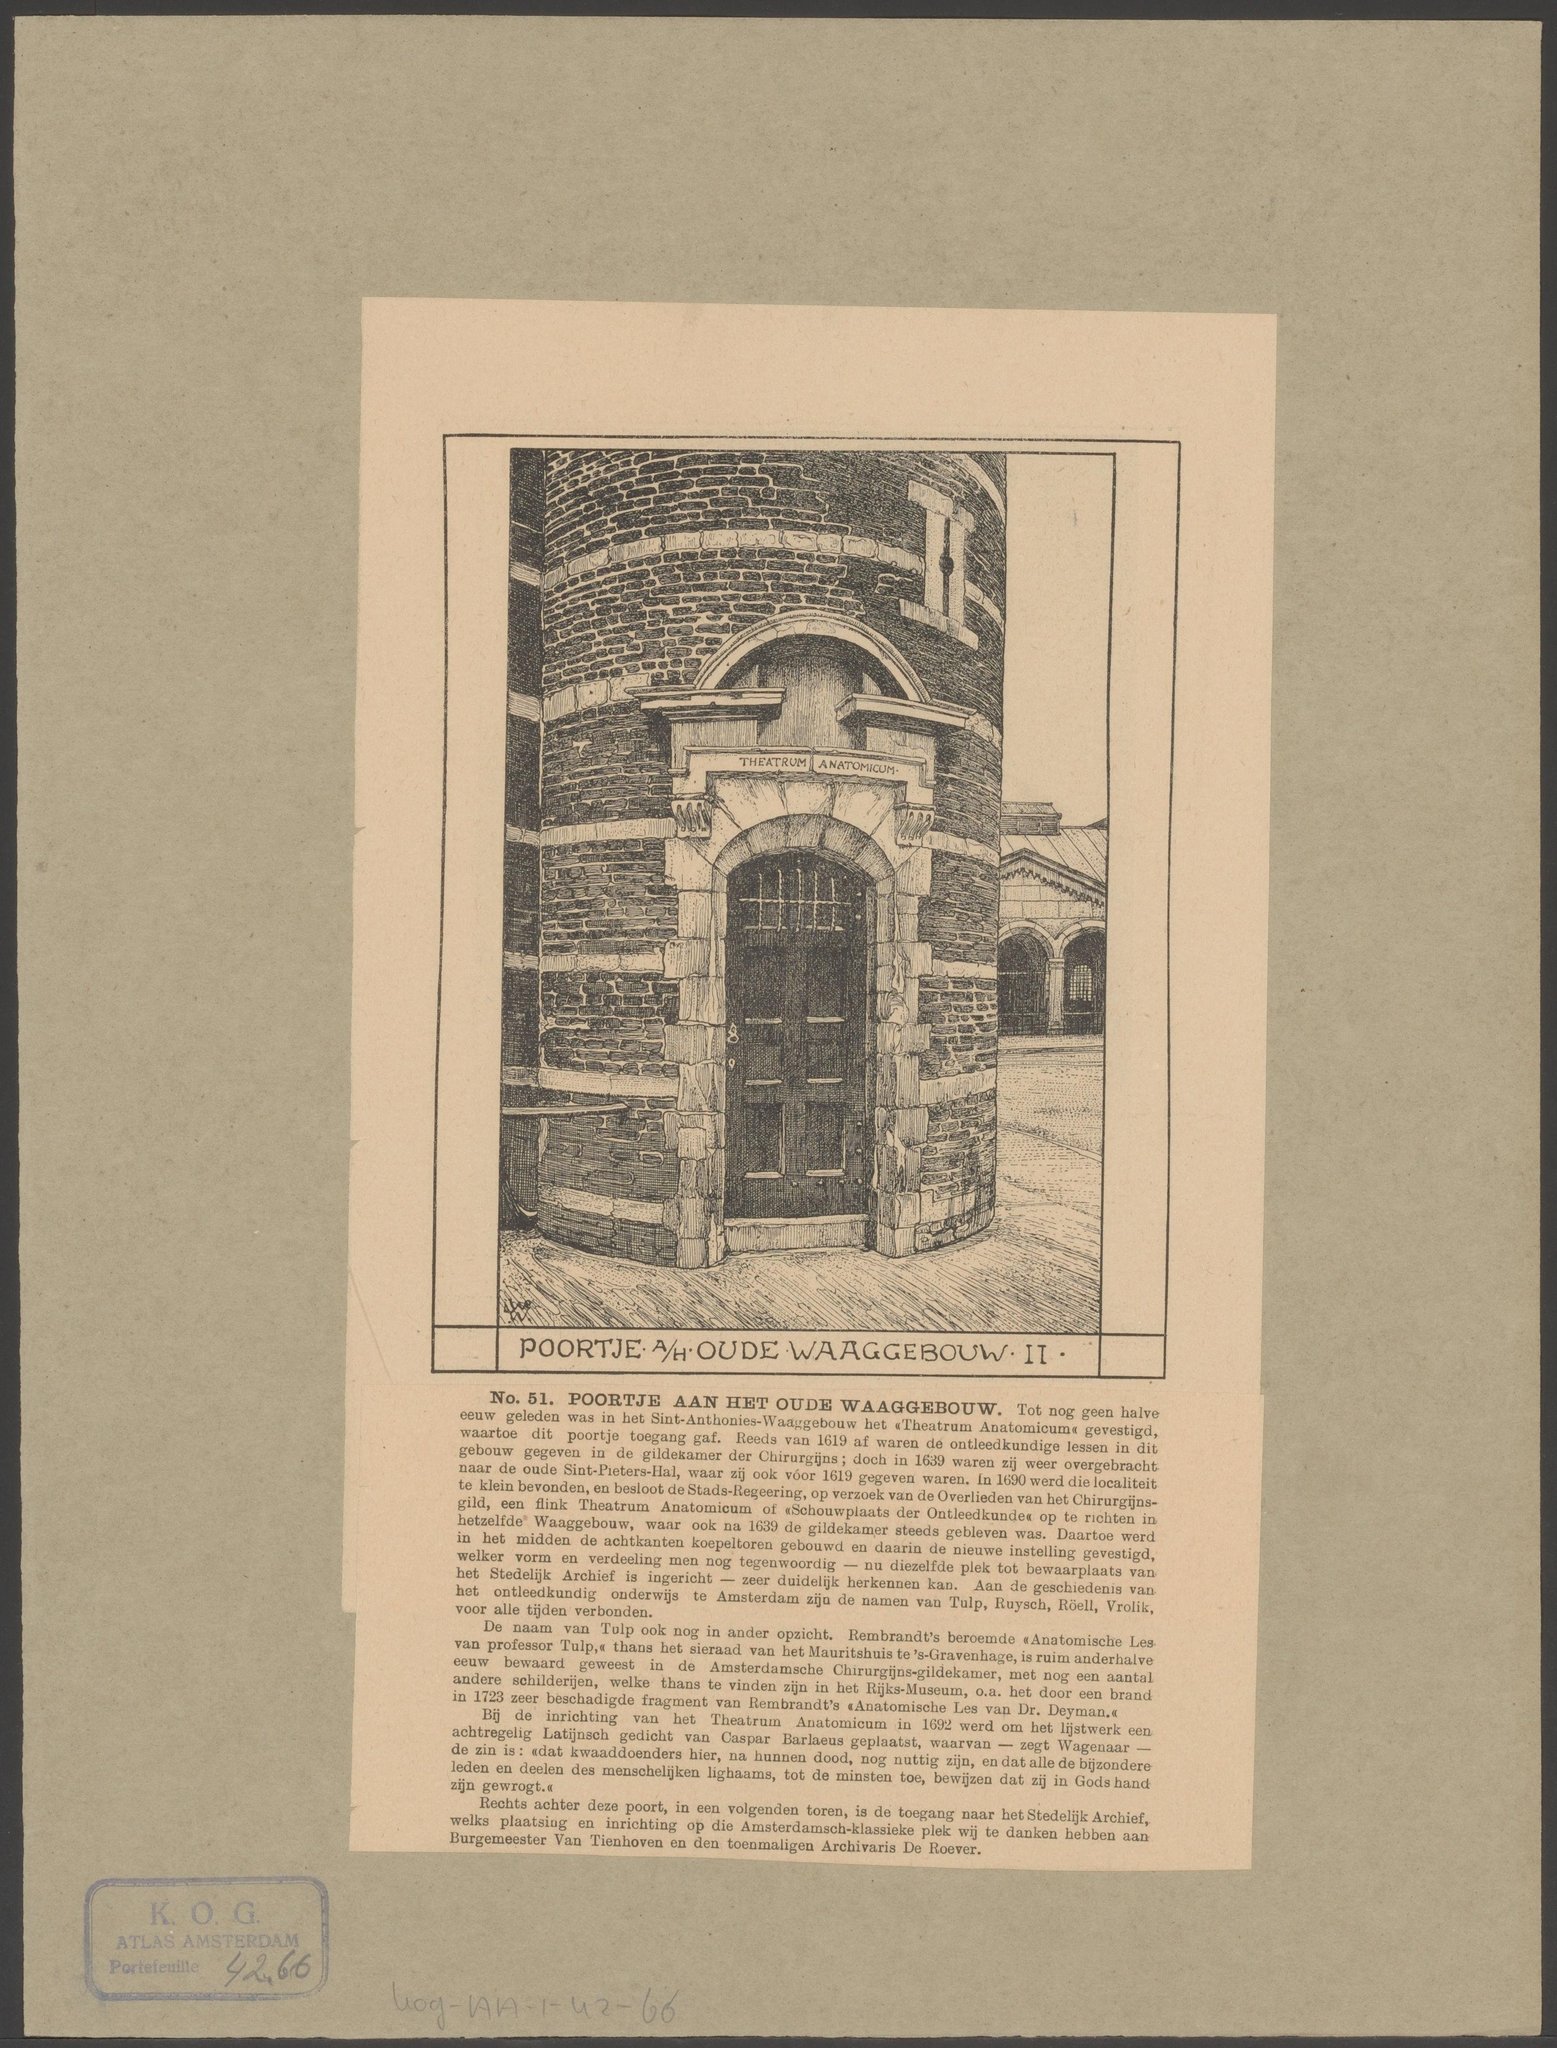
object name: photomechanical print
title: Poort van het Theatrum Anatomicum in de Waag op de Nieuwmarkt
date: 1907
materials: paper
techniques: letterpress printing, line block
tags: weigh-house, amsterdam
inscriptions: collector's mark: Lugt 1461b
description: Prent mogelijk uit: Wenckebach, Ludwig Willem Reymert. Oud-Amsterdam: 100 stadsgezichten. Amsterdam: Het Nieuws van de dag, 1907.